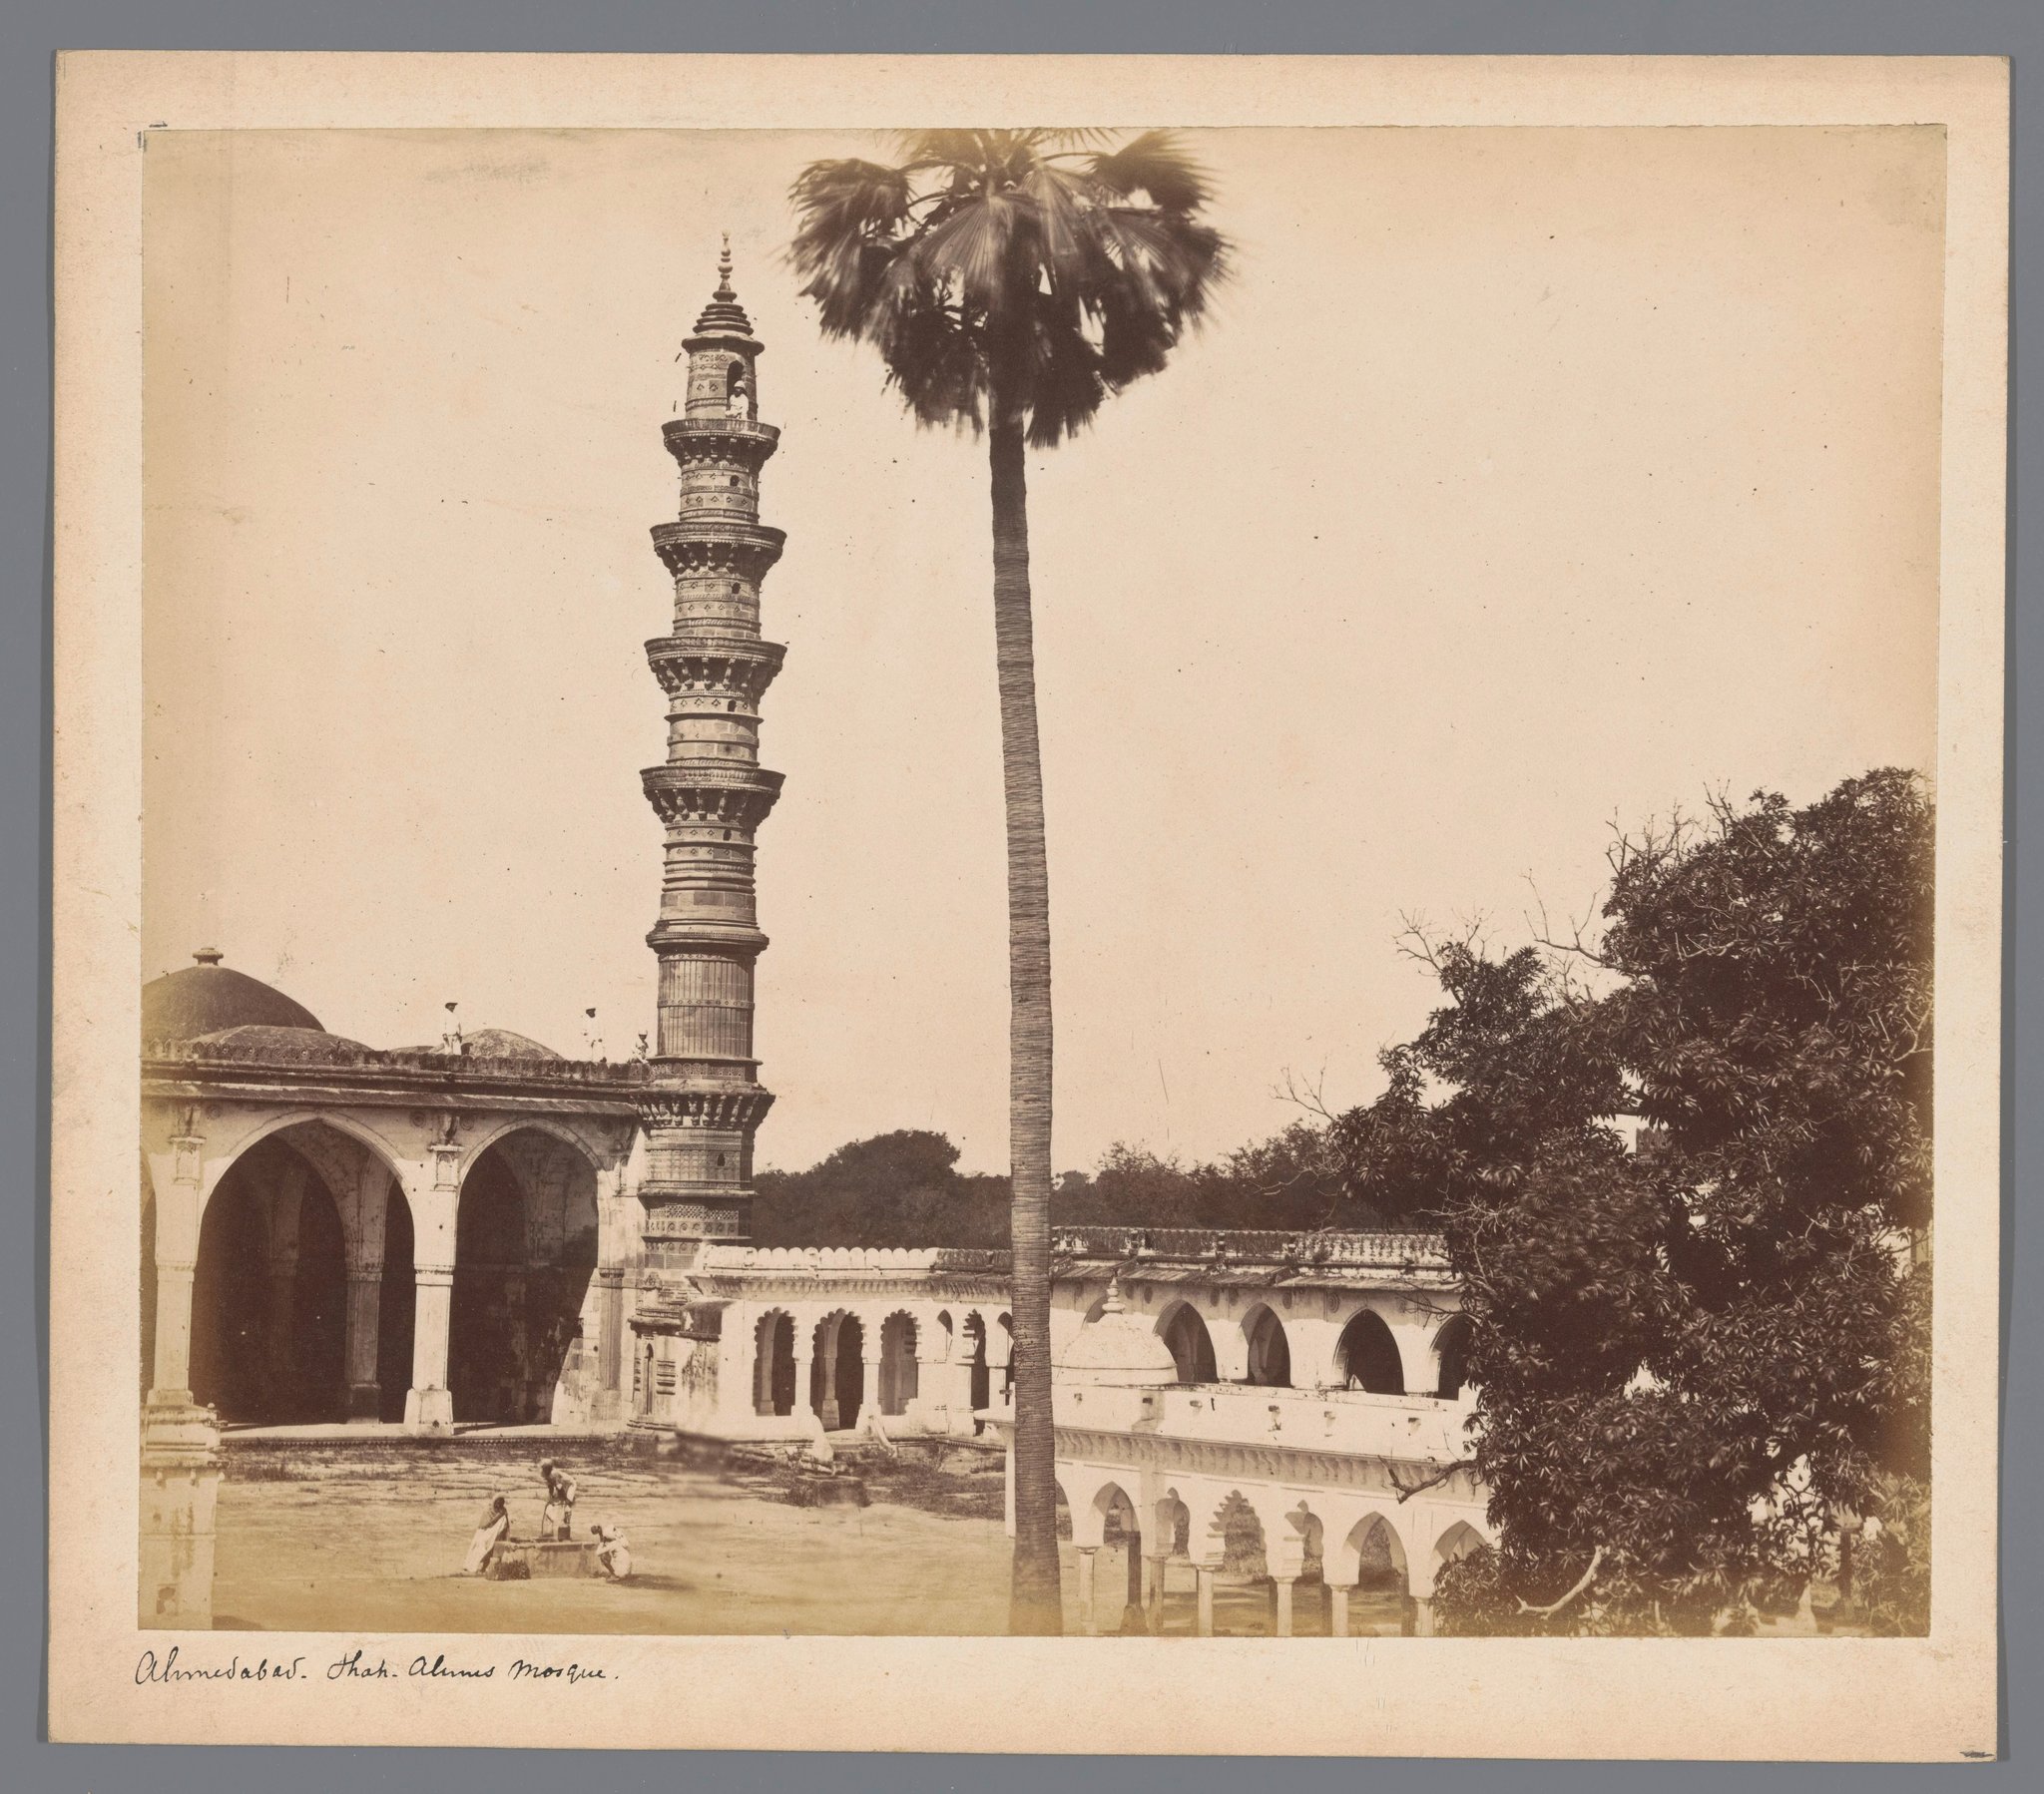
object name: photograph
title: Minaret of Shah-e-Alam's Roza in Ahmedebad, Gujarat, India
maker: Anonymous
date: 1865-1890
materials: cardboard, paper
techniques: albumen print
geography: ahmedabad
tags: temple, shrine ~ islam, mohammedanism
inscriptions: number: ‘12’, title: ‘Ahmedabad. Shah-Alums Mosque.’